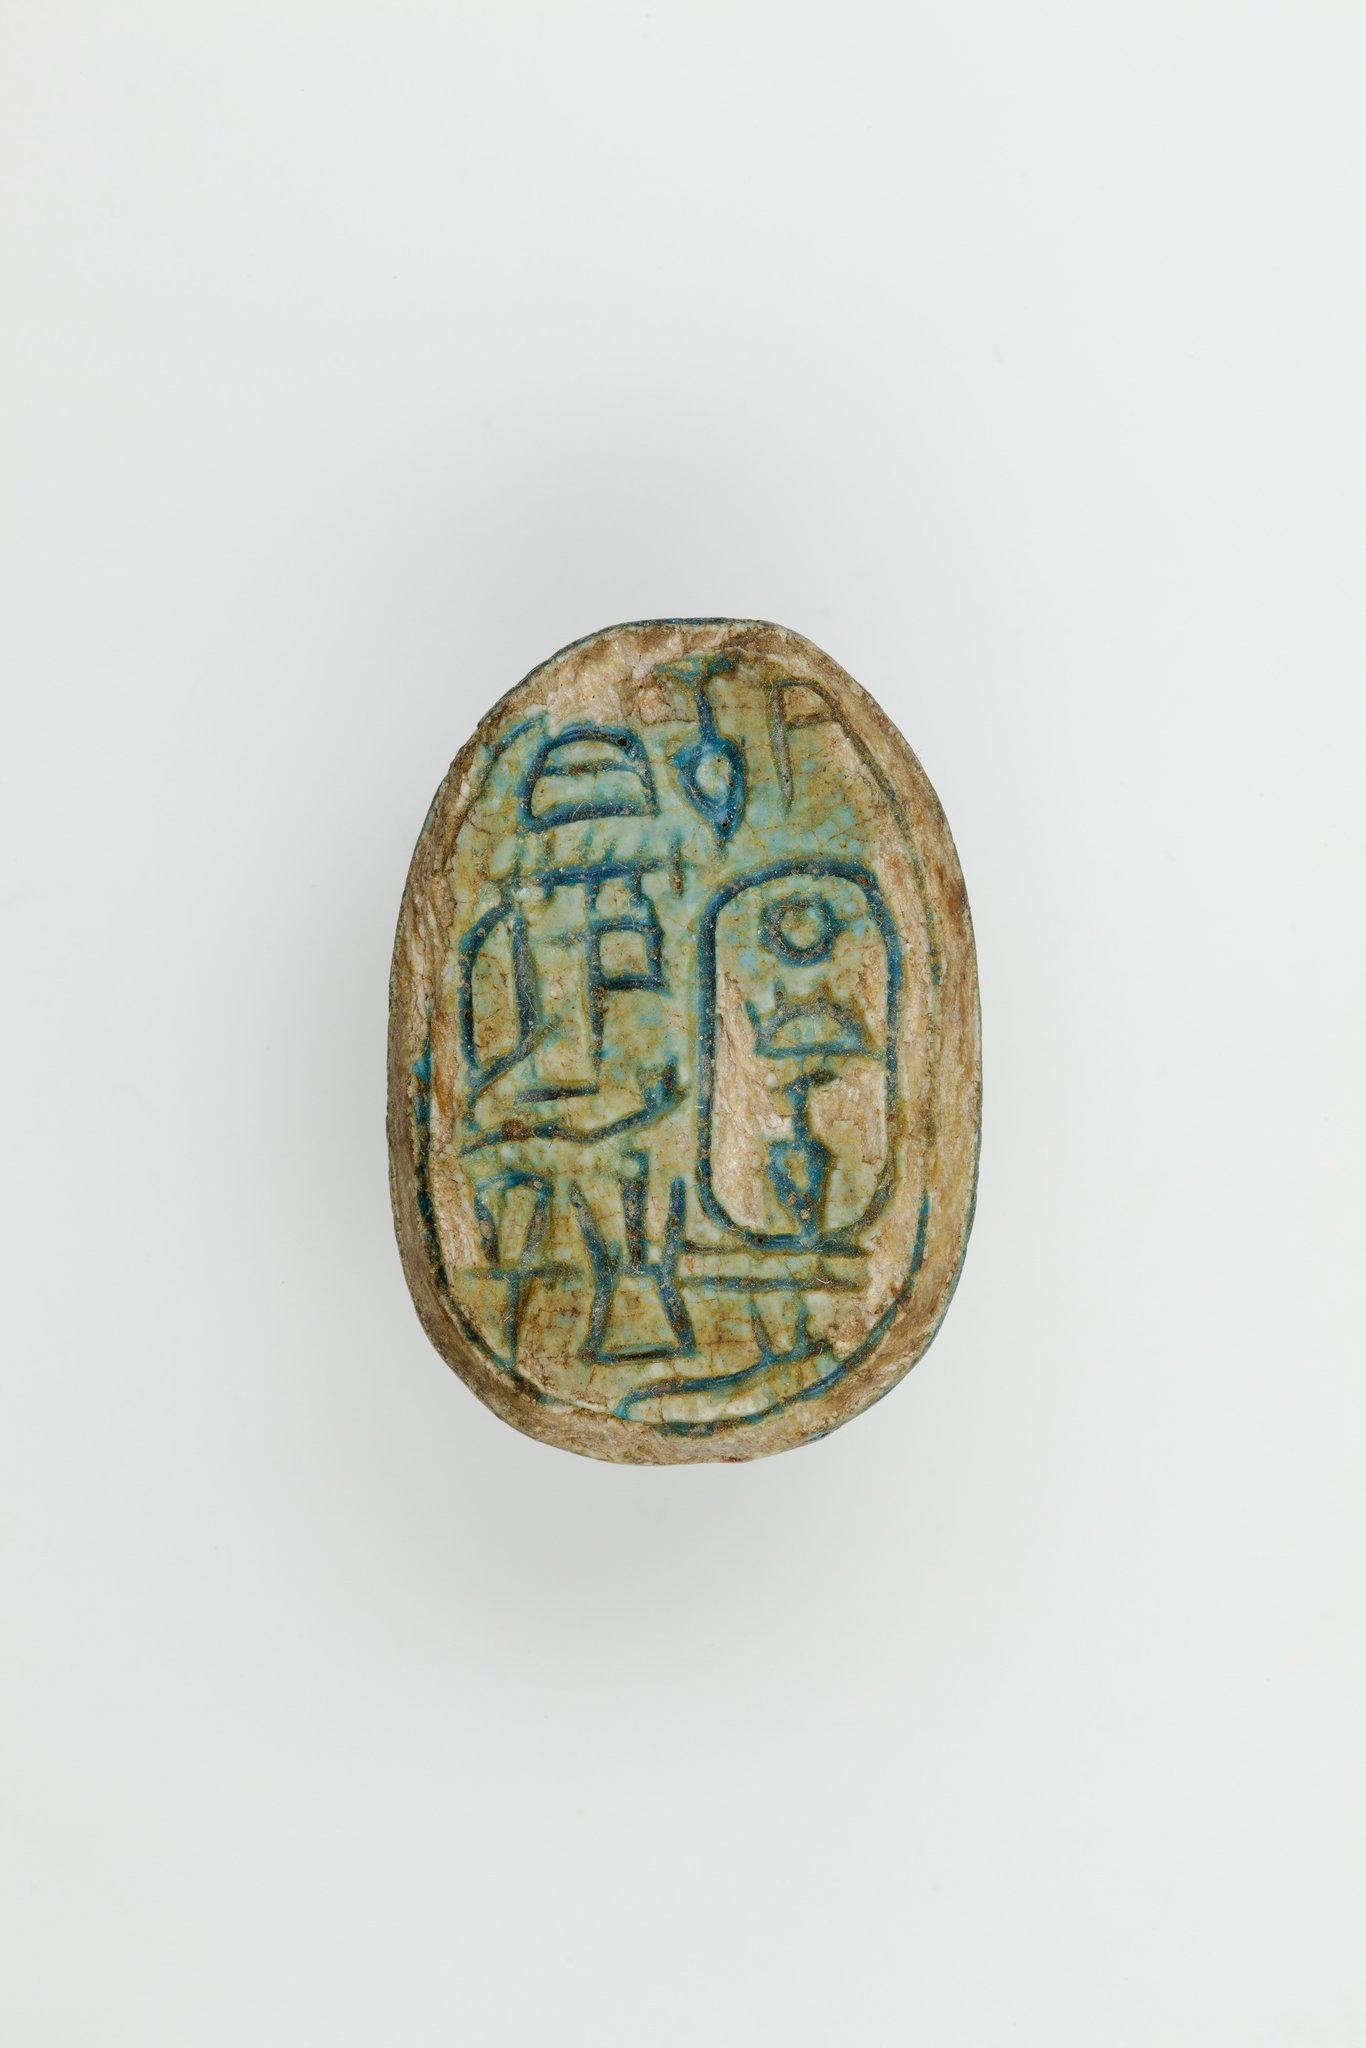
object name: scarab, khaneferre sebekhotep iv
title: Scarab of King Khaneferre Sebekhotep IV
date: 1731-1719 BCE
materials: stone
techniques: glazing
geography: egypt